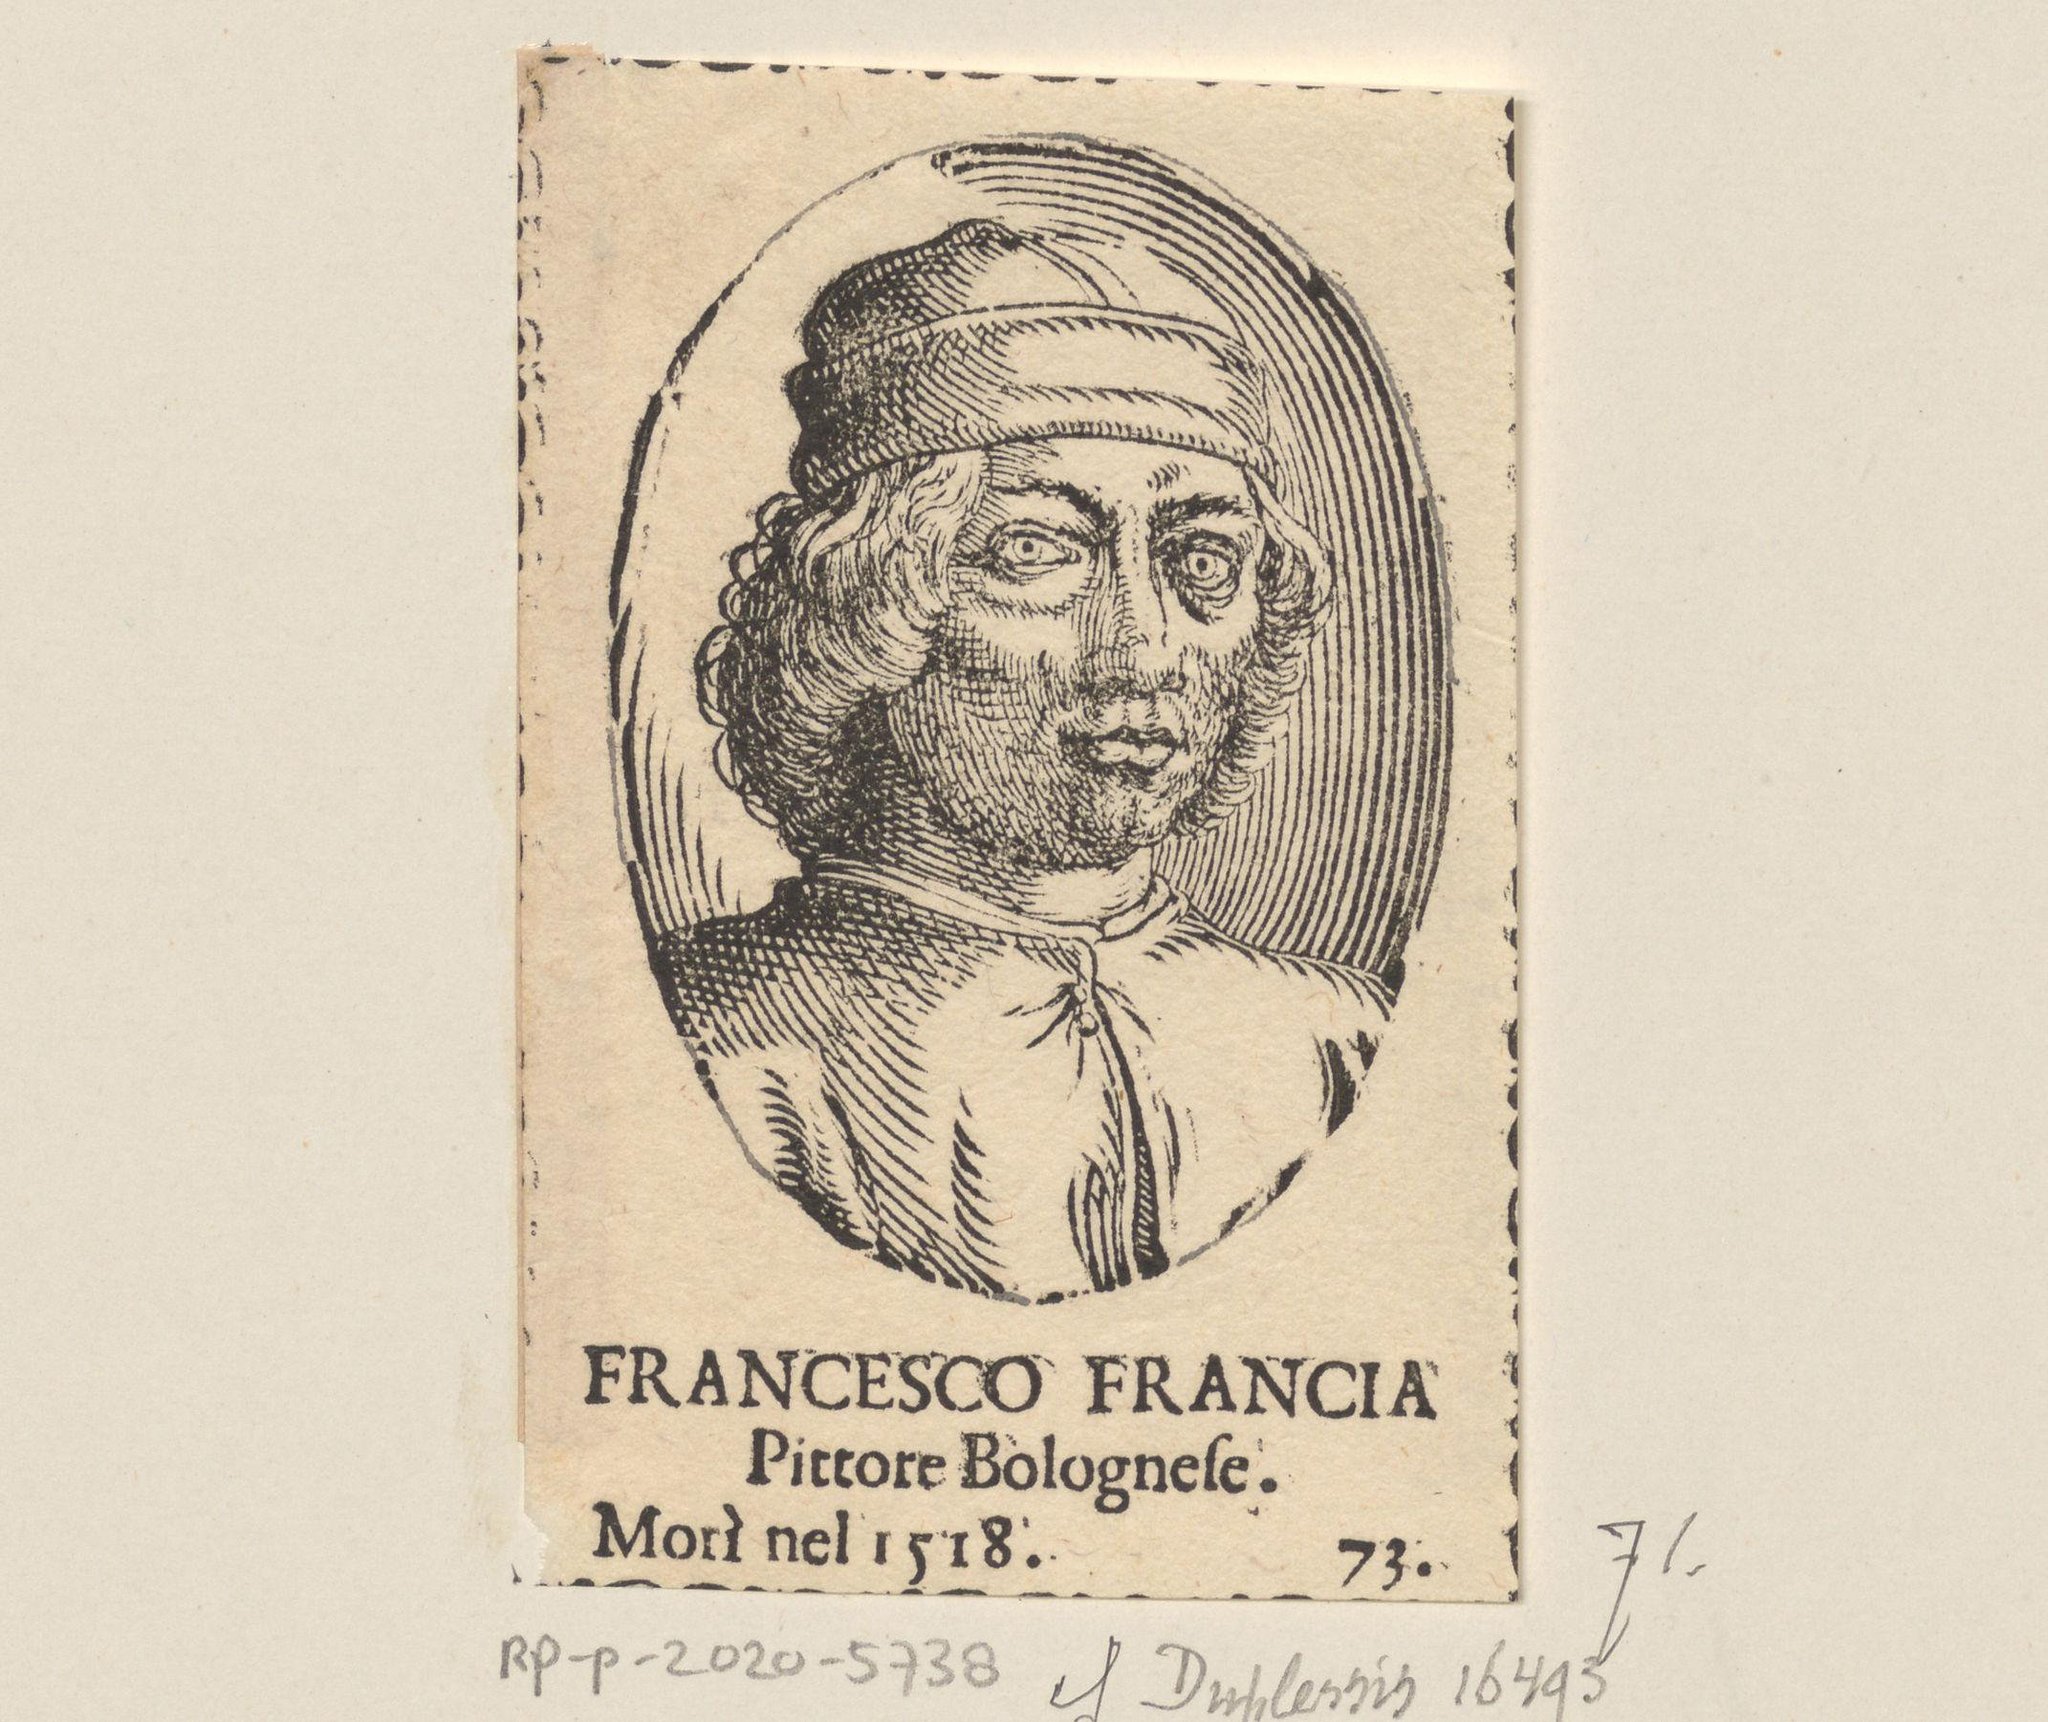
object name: print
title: Portret van Francesco di Francia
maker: cristoforo coriolano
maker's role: print maker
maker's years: 1540-1610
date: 1568-1650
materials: paper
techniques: letterpress printing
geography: italy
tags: painter, francesco di francia, portrait, self-portrait of sculptor, historical persons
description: Prent komt uit een editie van Vasari's 'Vite'. Prent met een andere omlijsting is gebruikt in de editie uit 1568: Vasari, Giorgio. Le vite de' piu eccellenti pittori scultori, e architettori. Florence: Filippo Giunta, 1568. En mogelijk in de editie uit 1647.